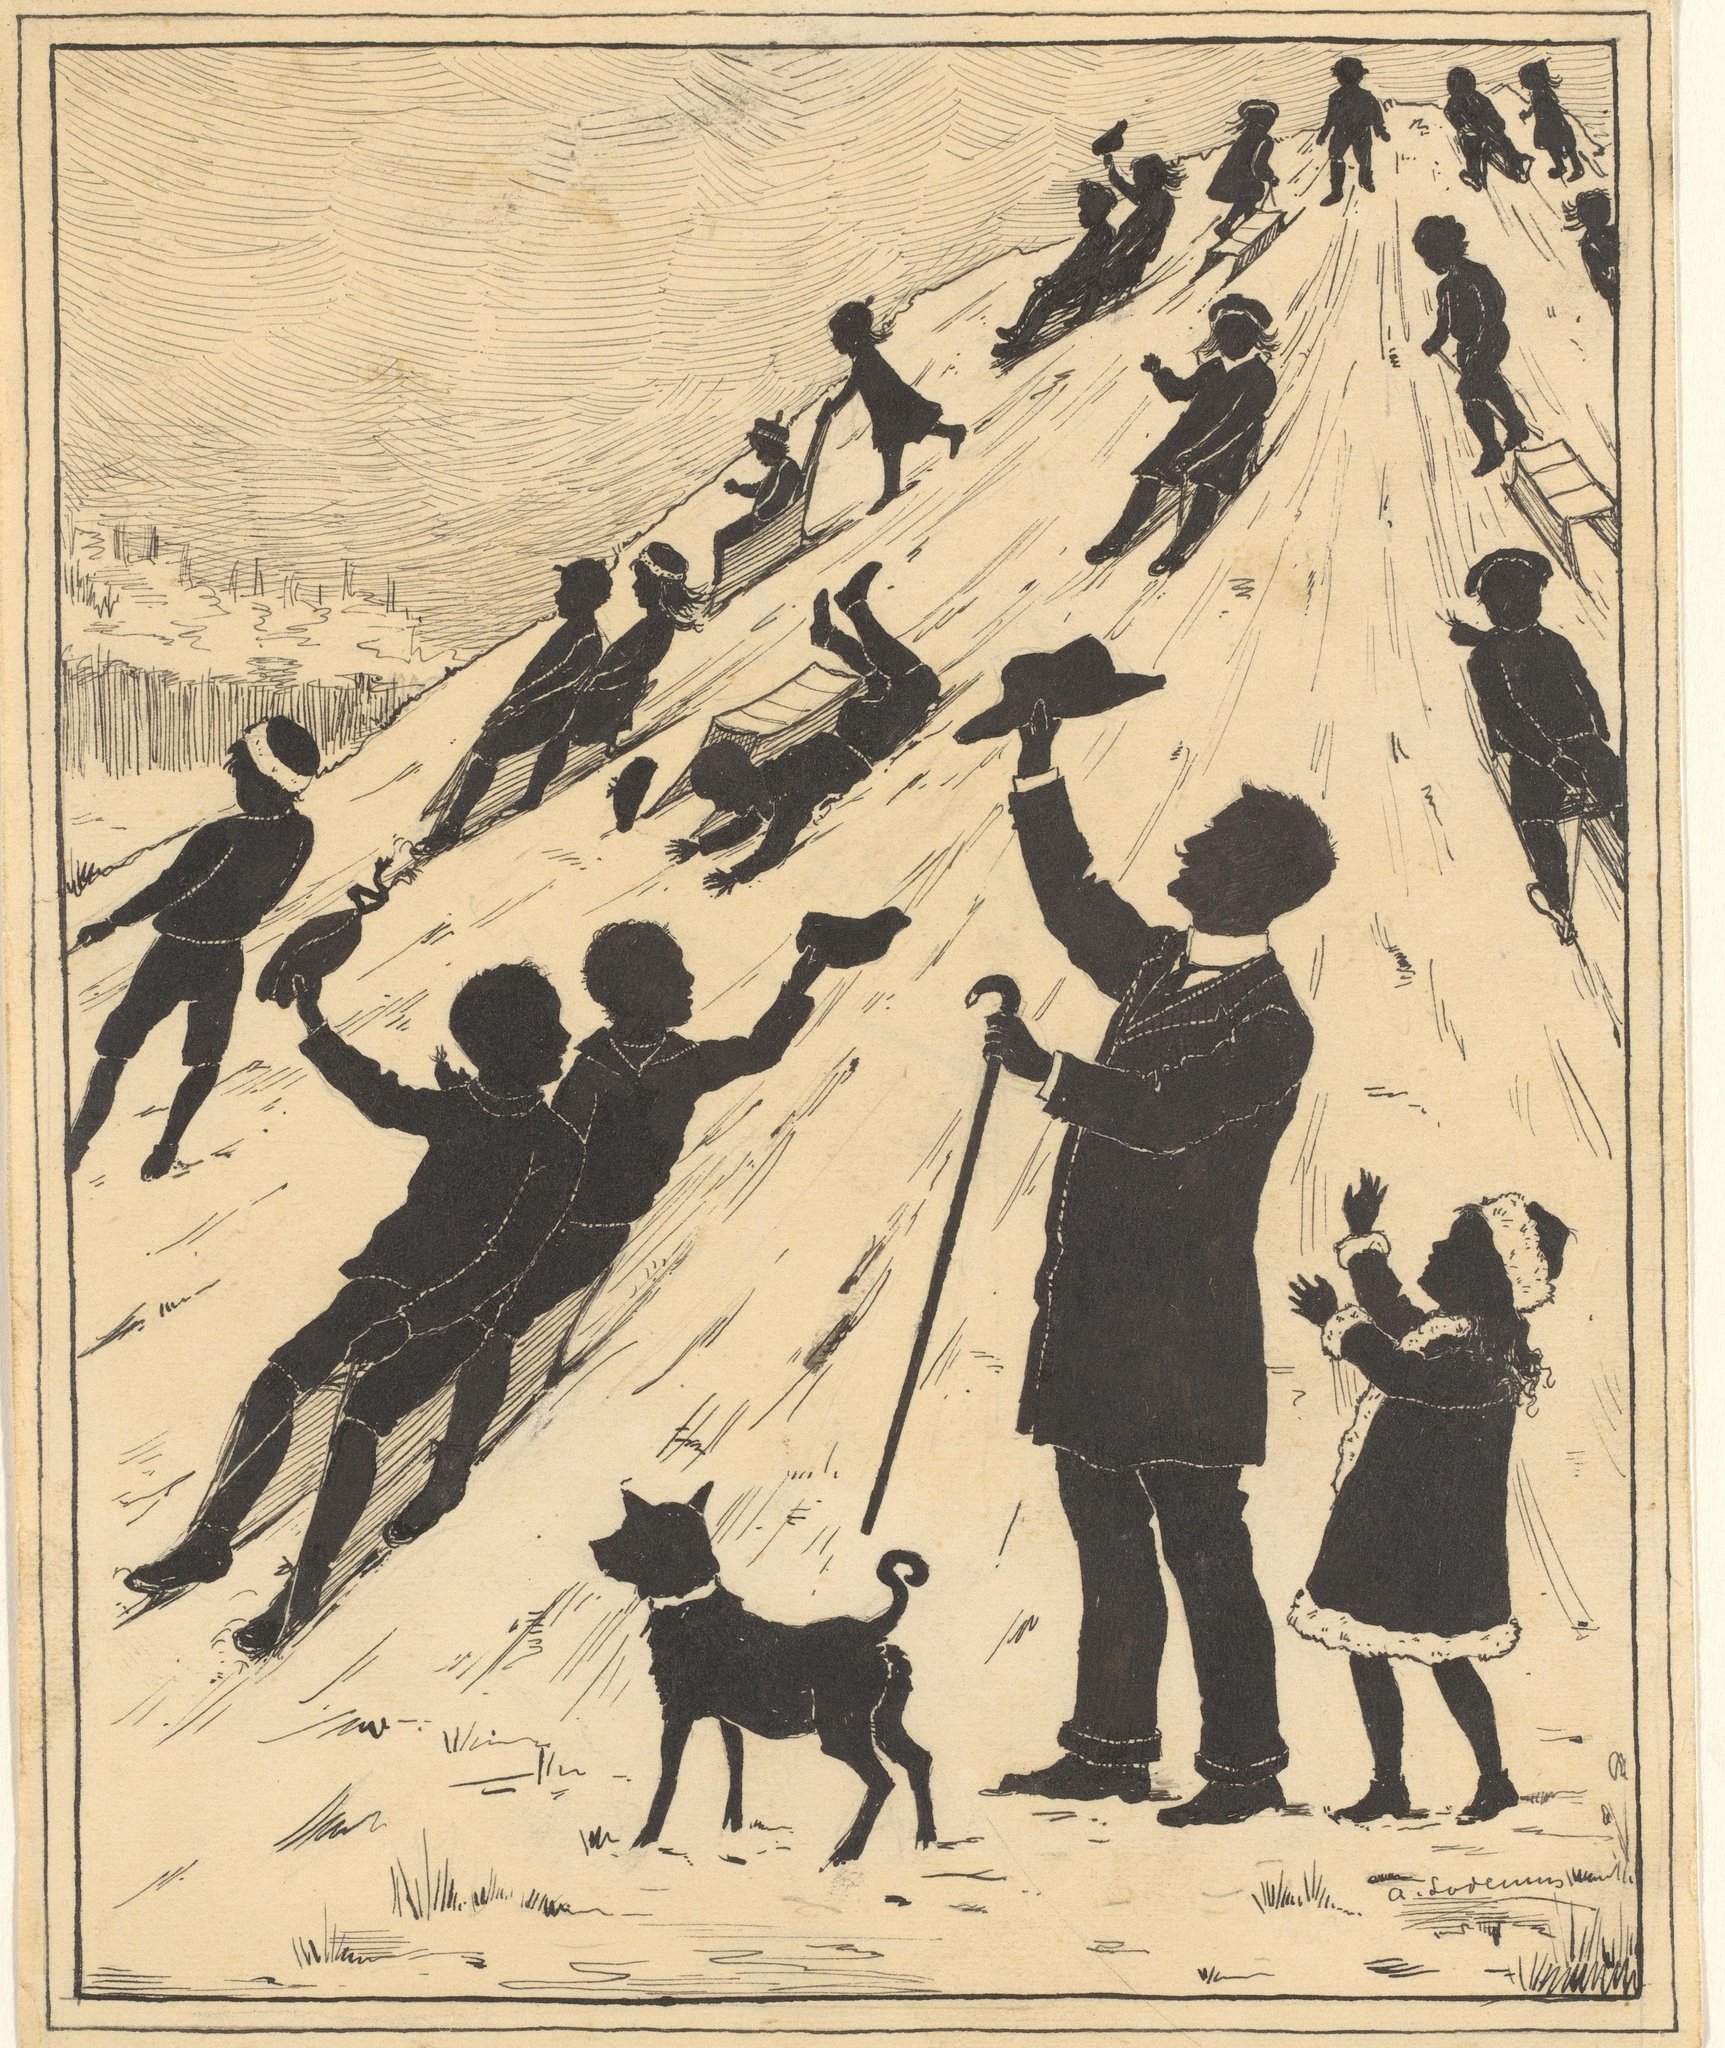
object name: drawing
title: Kinderen sleeën van een berg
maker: adri ladenius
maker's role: draughtsman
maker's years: 1883-1953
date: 1893-1953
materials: ink, paper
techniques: pen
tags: (high) hill, sledge, sleigh (winter sports), dog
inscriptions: :, signature: ‘A. Ladenius’, collector's mark: Lugt 2228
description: Kinderen sleeën van een steile besneeuwde berg. Onderaan de berg staan een meisje en een man met een hond. De man houdt een wandelstok vast en tilt zijn hoed op.